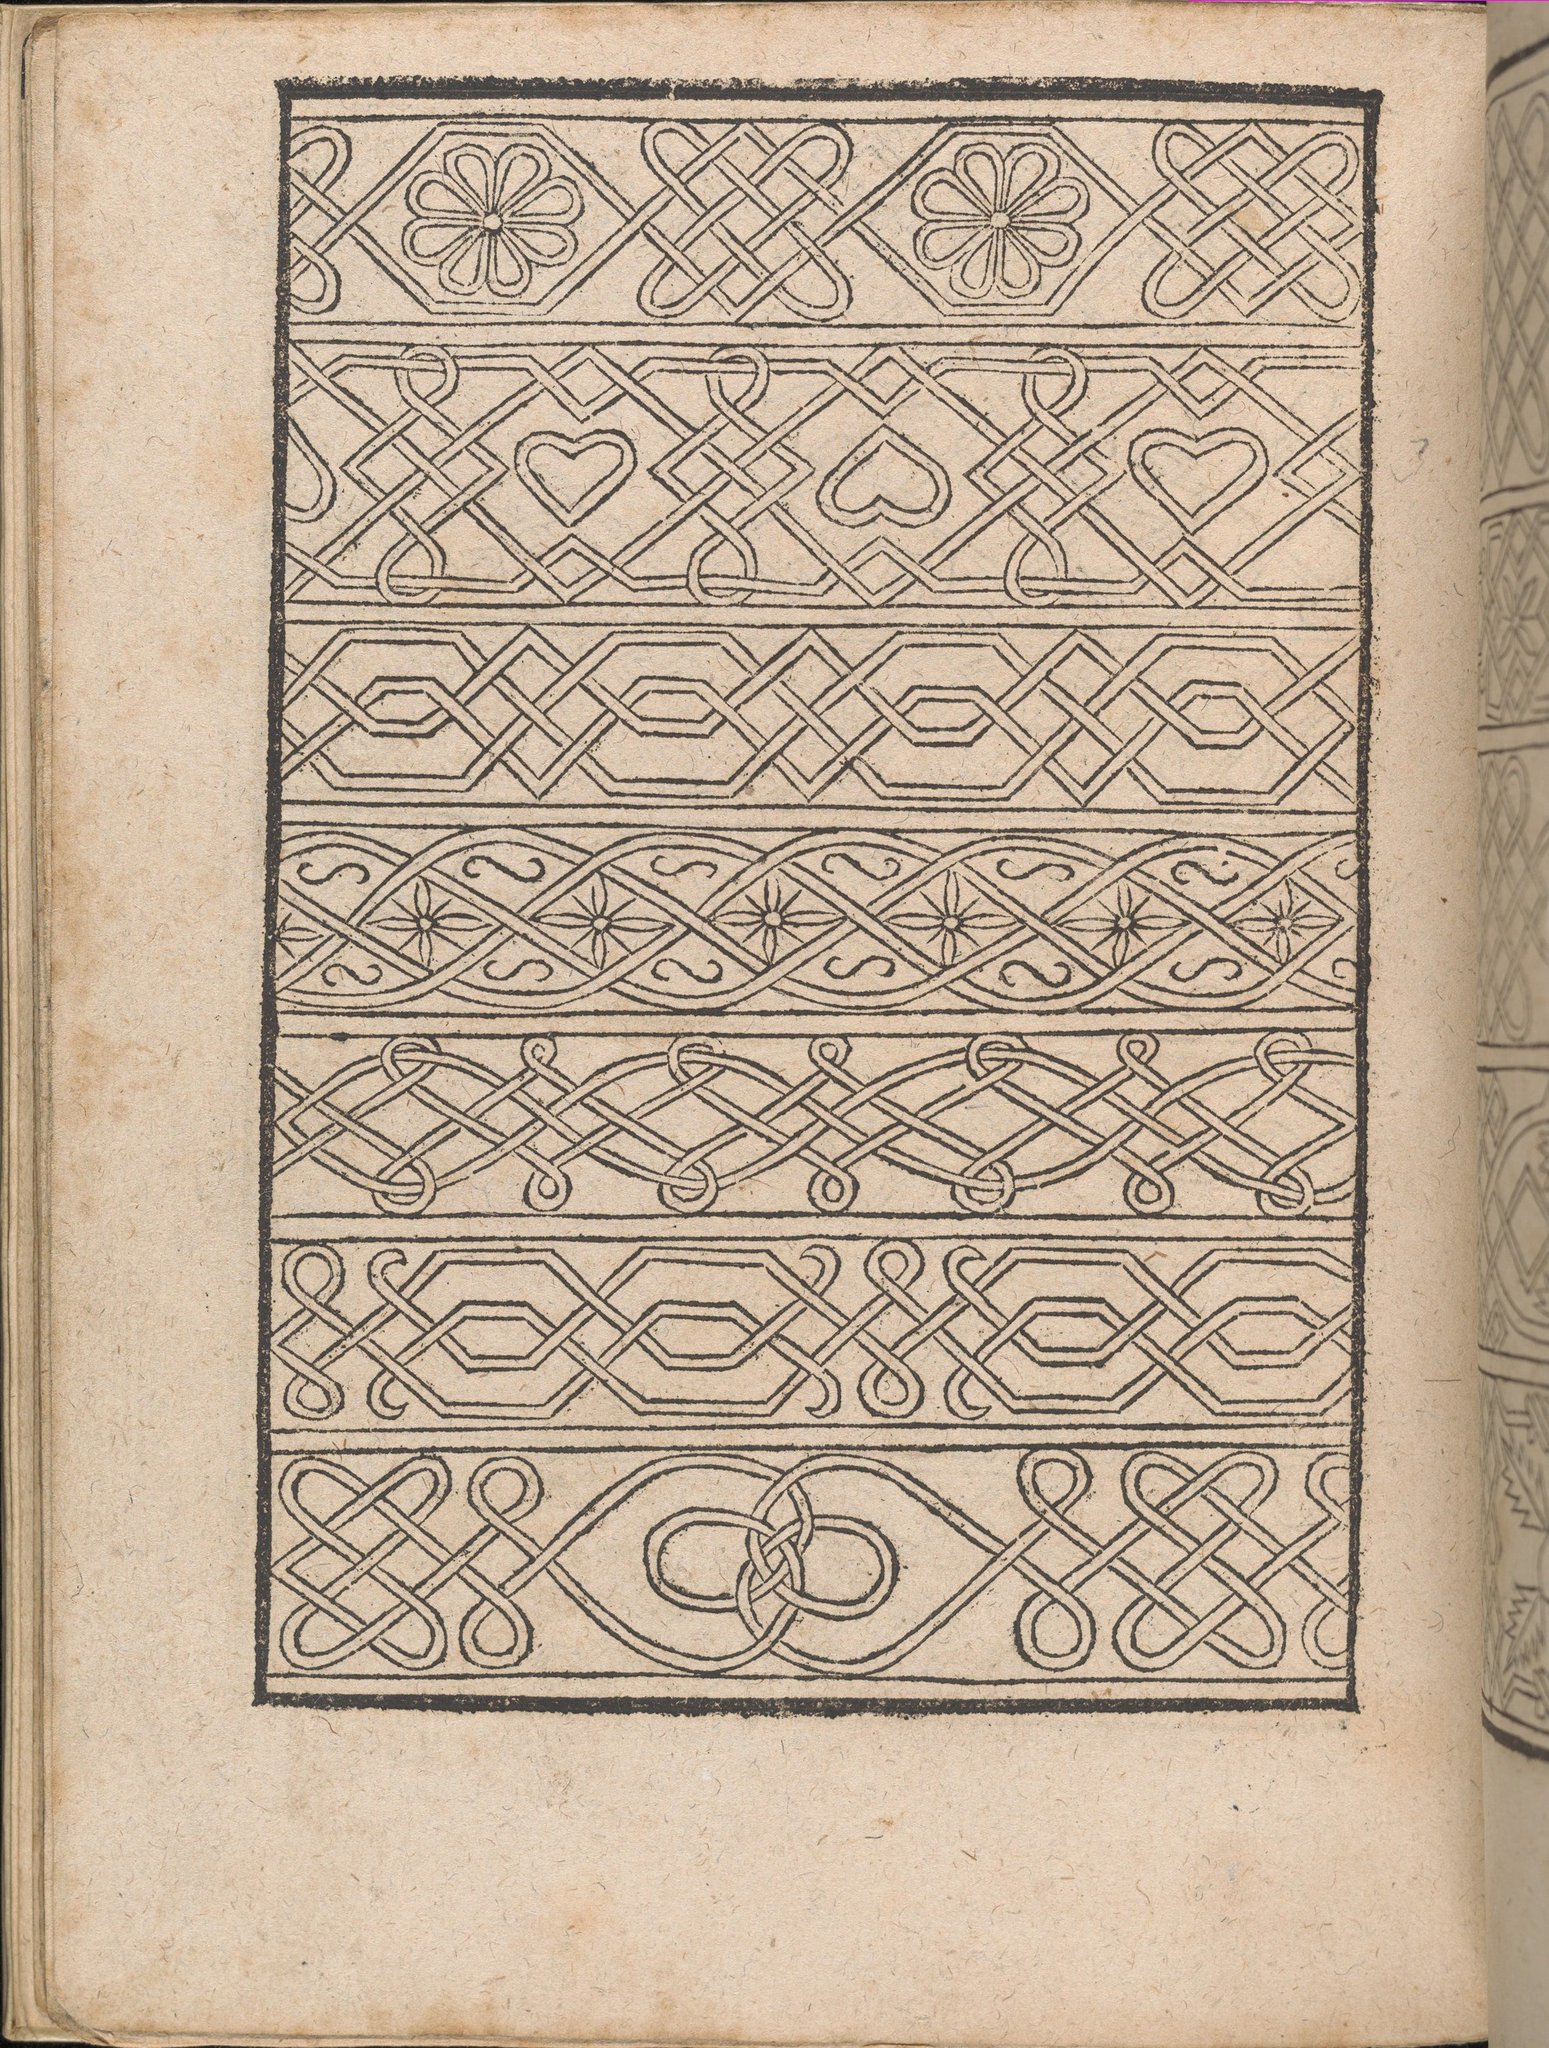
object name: book print ornament architecture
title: New Modelbüch allen Nägerin u. Sydenstickern (Page 13v)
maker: hans hoffman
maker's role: designer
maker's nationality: german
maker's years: 1556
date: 1556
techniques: woodcut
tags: ornament